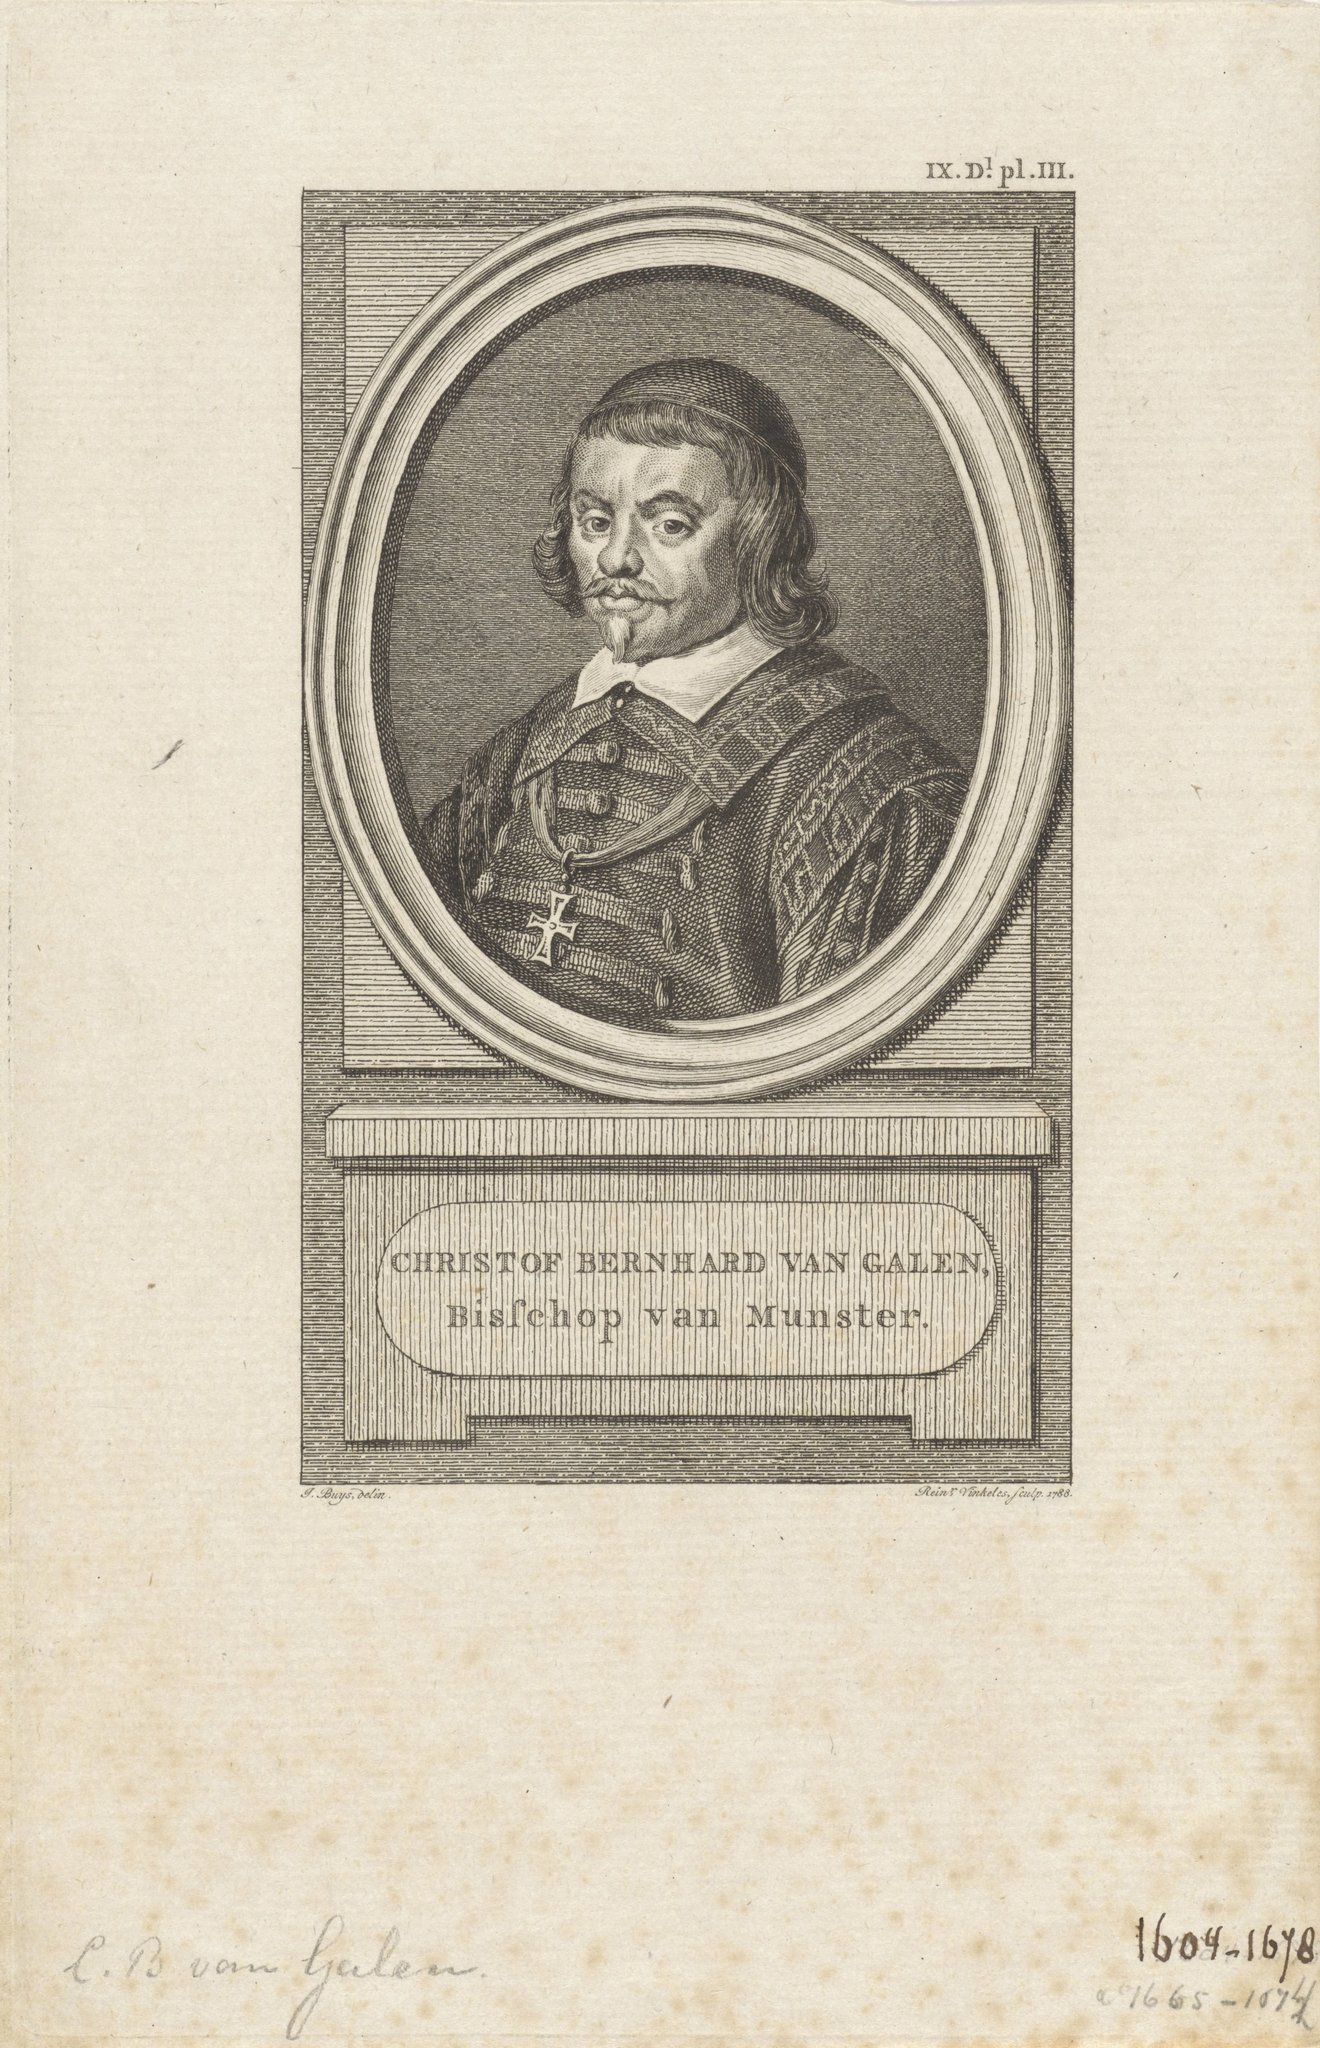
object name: book illustration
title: Christoph Bernhard von Galen, bisschop van Münster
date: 1788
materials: paper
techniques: etching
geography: amsterdam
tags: bisschop, christoph bernhard von galen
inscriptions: collector's mark: Lugt 2228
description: Prent gebruikt als boekillustratie in: Kok, Jacobus. Vaderlandsch woordenboek : met kaarten, plaaten en pourtraitten. Amsterdam: Johannes Allart, 1785-1796. Deel IX.